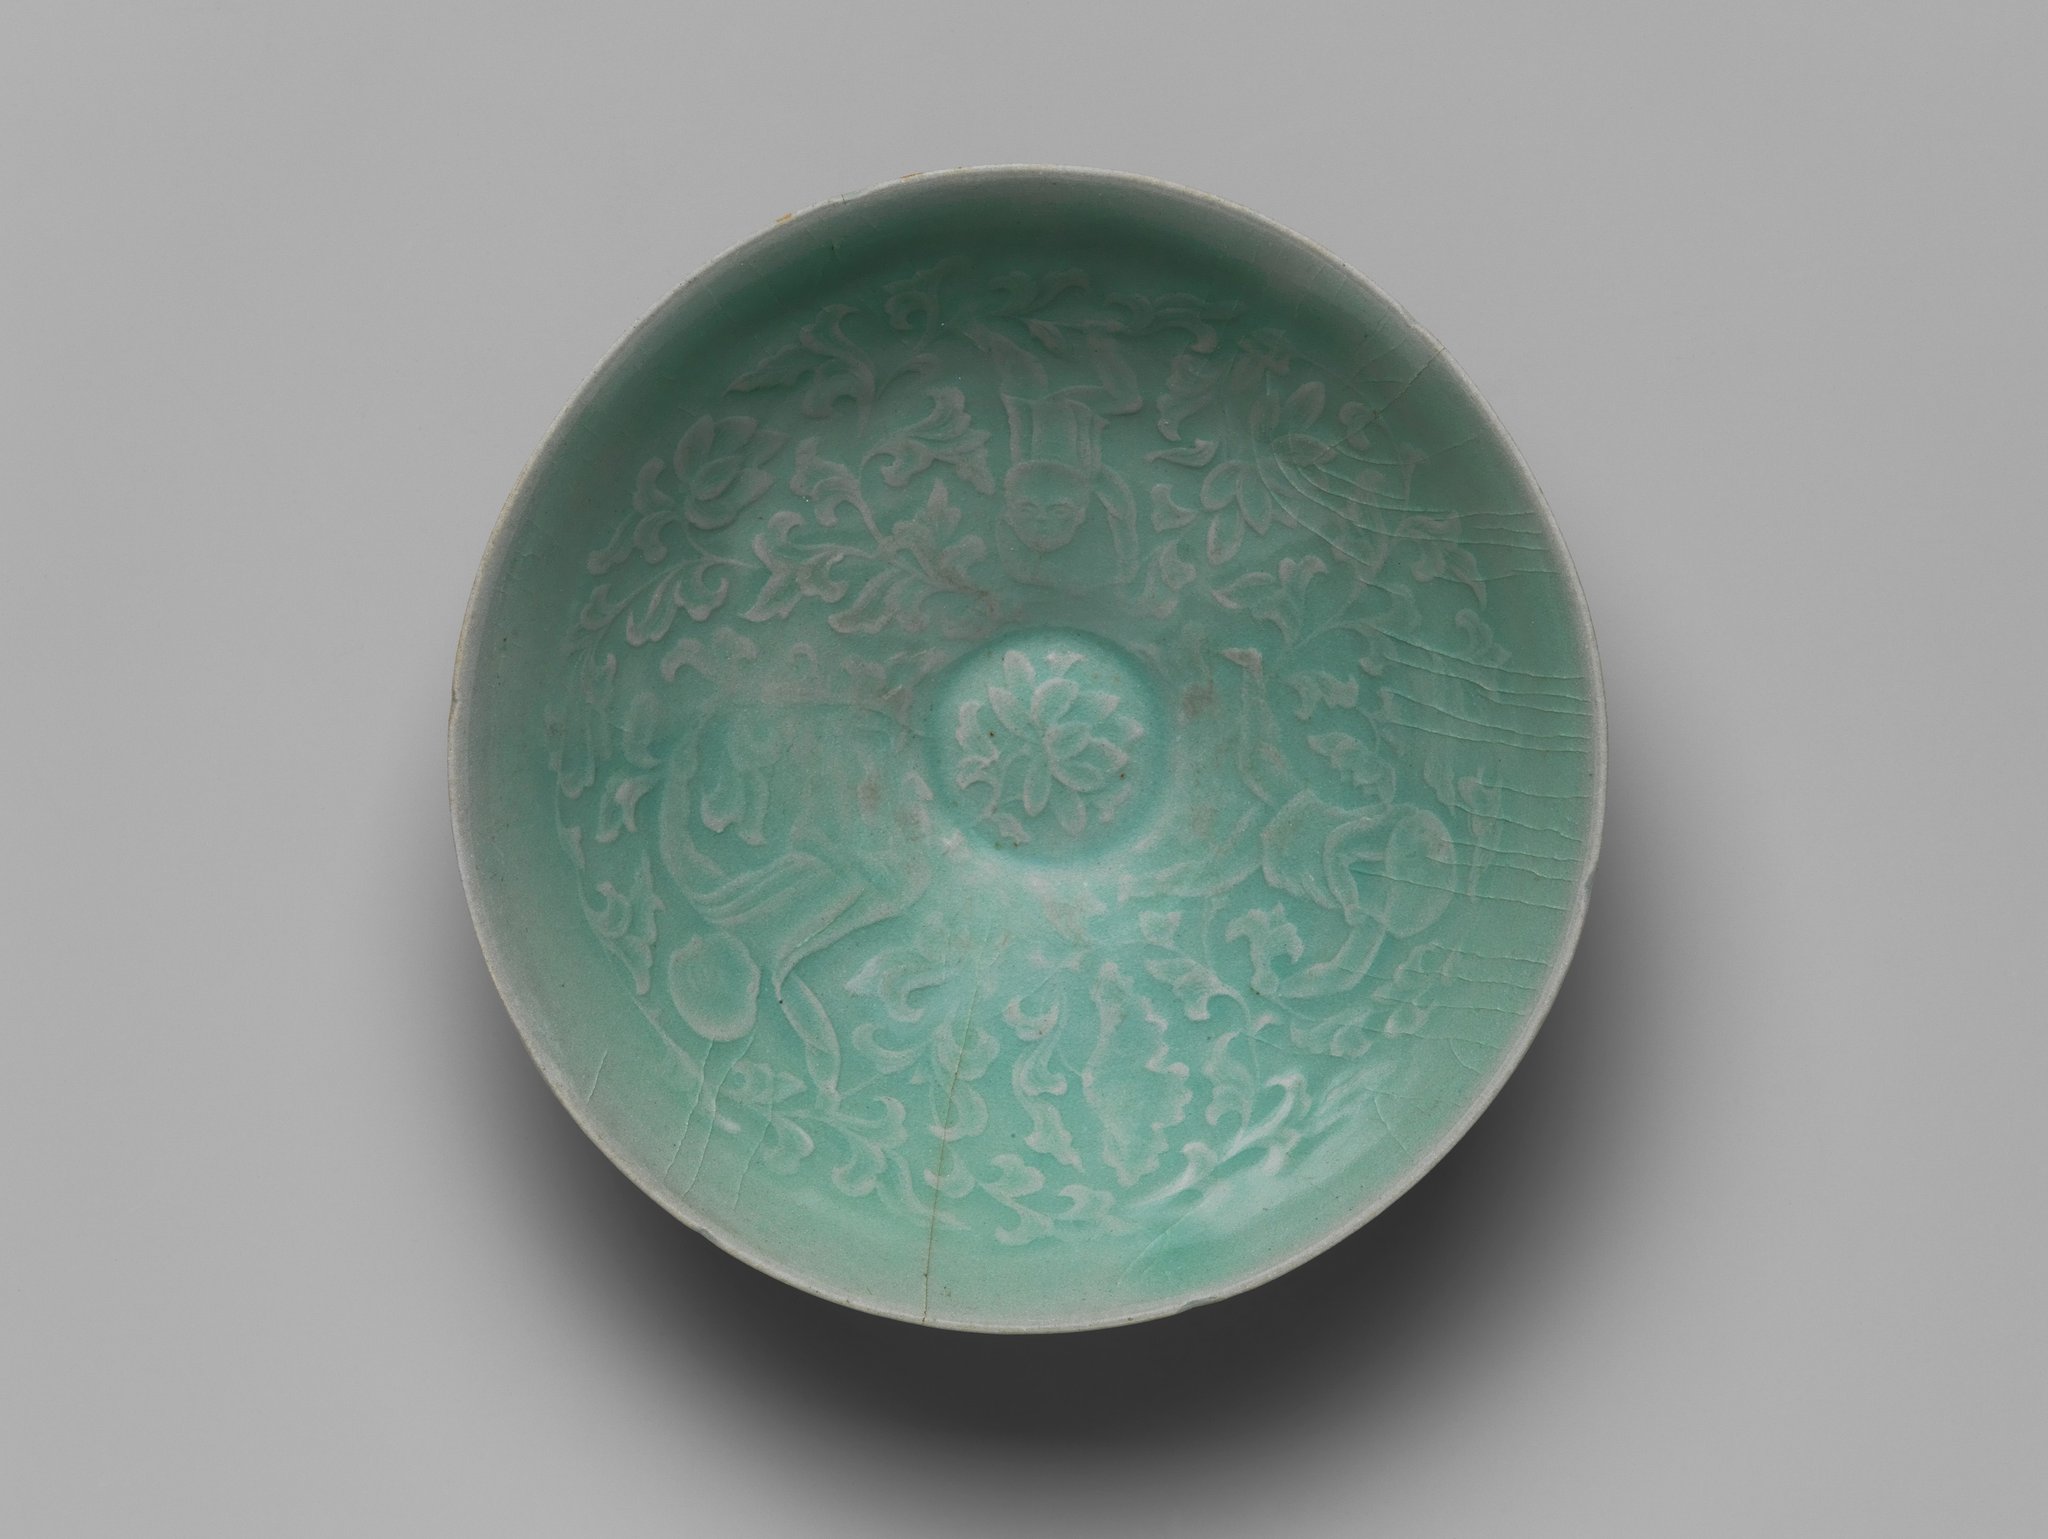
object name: bowl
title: Bowl with two boys and lotuses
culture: korean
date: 1101-1133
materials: ceramic glaze, glaze, stoneware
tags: boys,lotuses